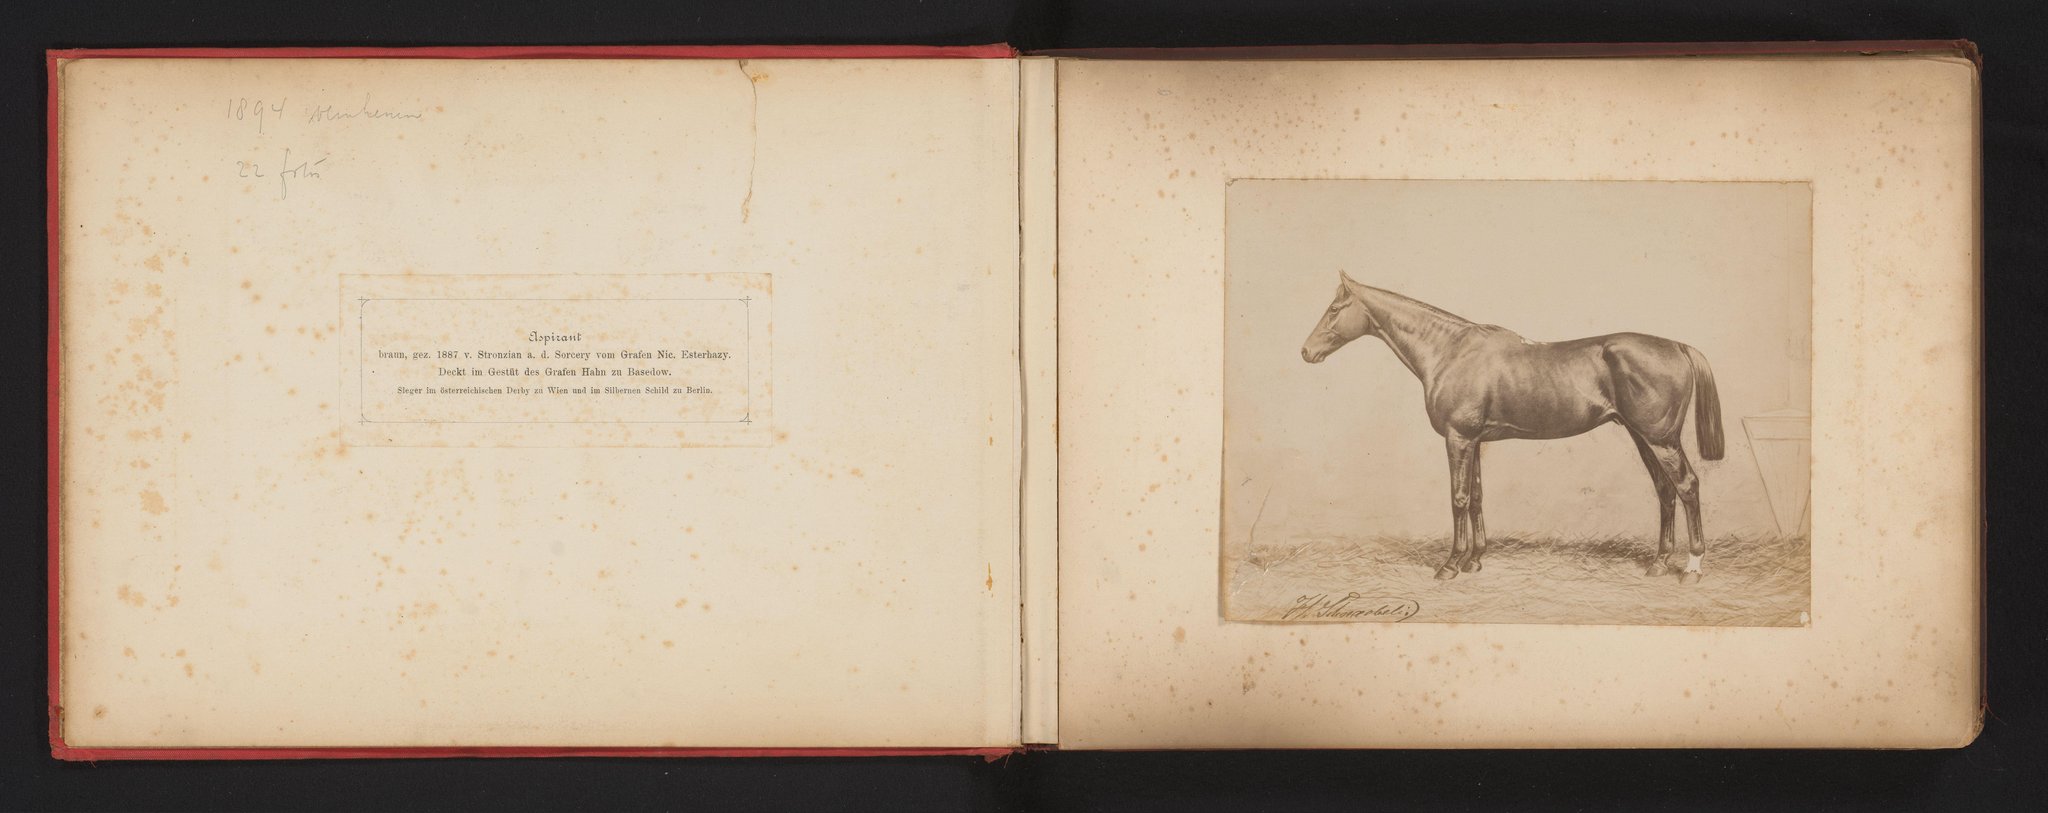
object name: photograph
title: Fotoreproductie van een tekening van een paard door H. Schnaebeli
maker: h. schnaebeli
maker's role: fotograaf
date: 1894-1915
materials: photographic support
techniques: albumen print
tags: horse